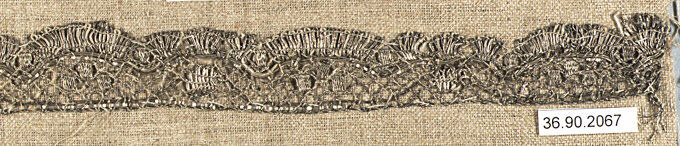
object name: piece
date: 1701-1800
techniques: lace